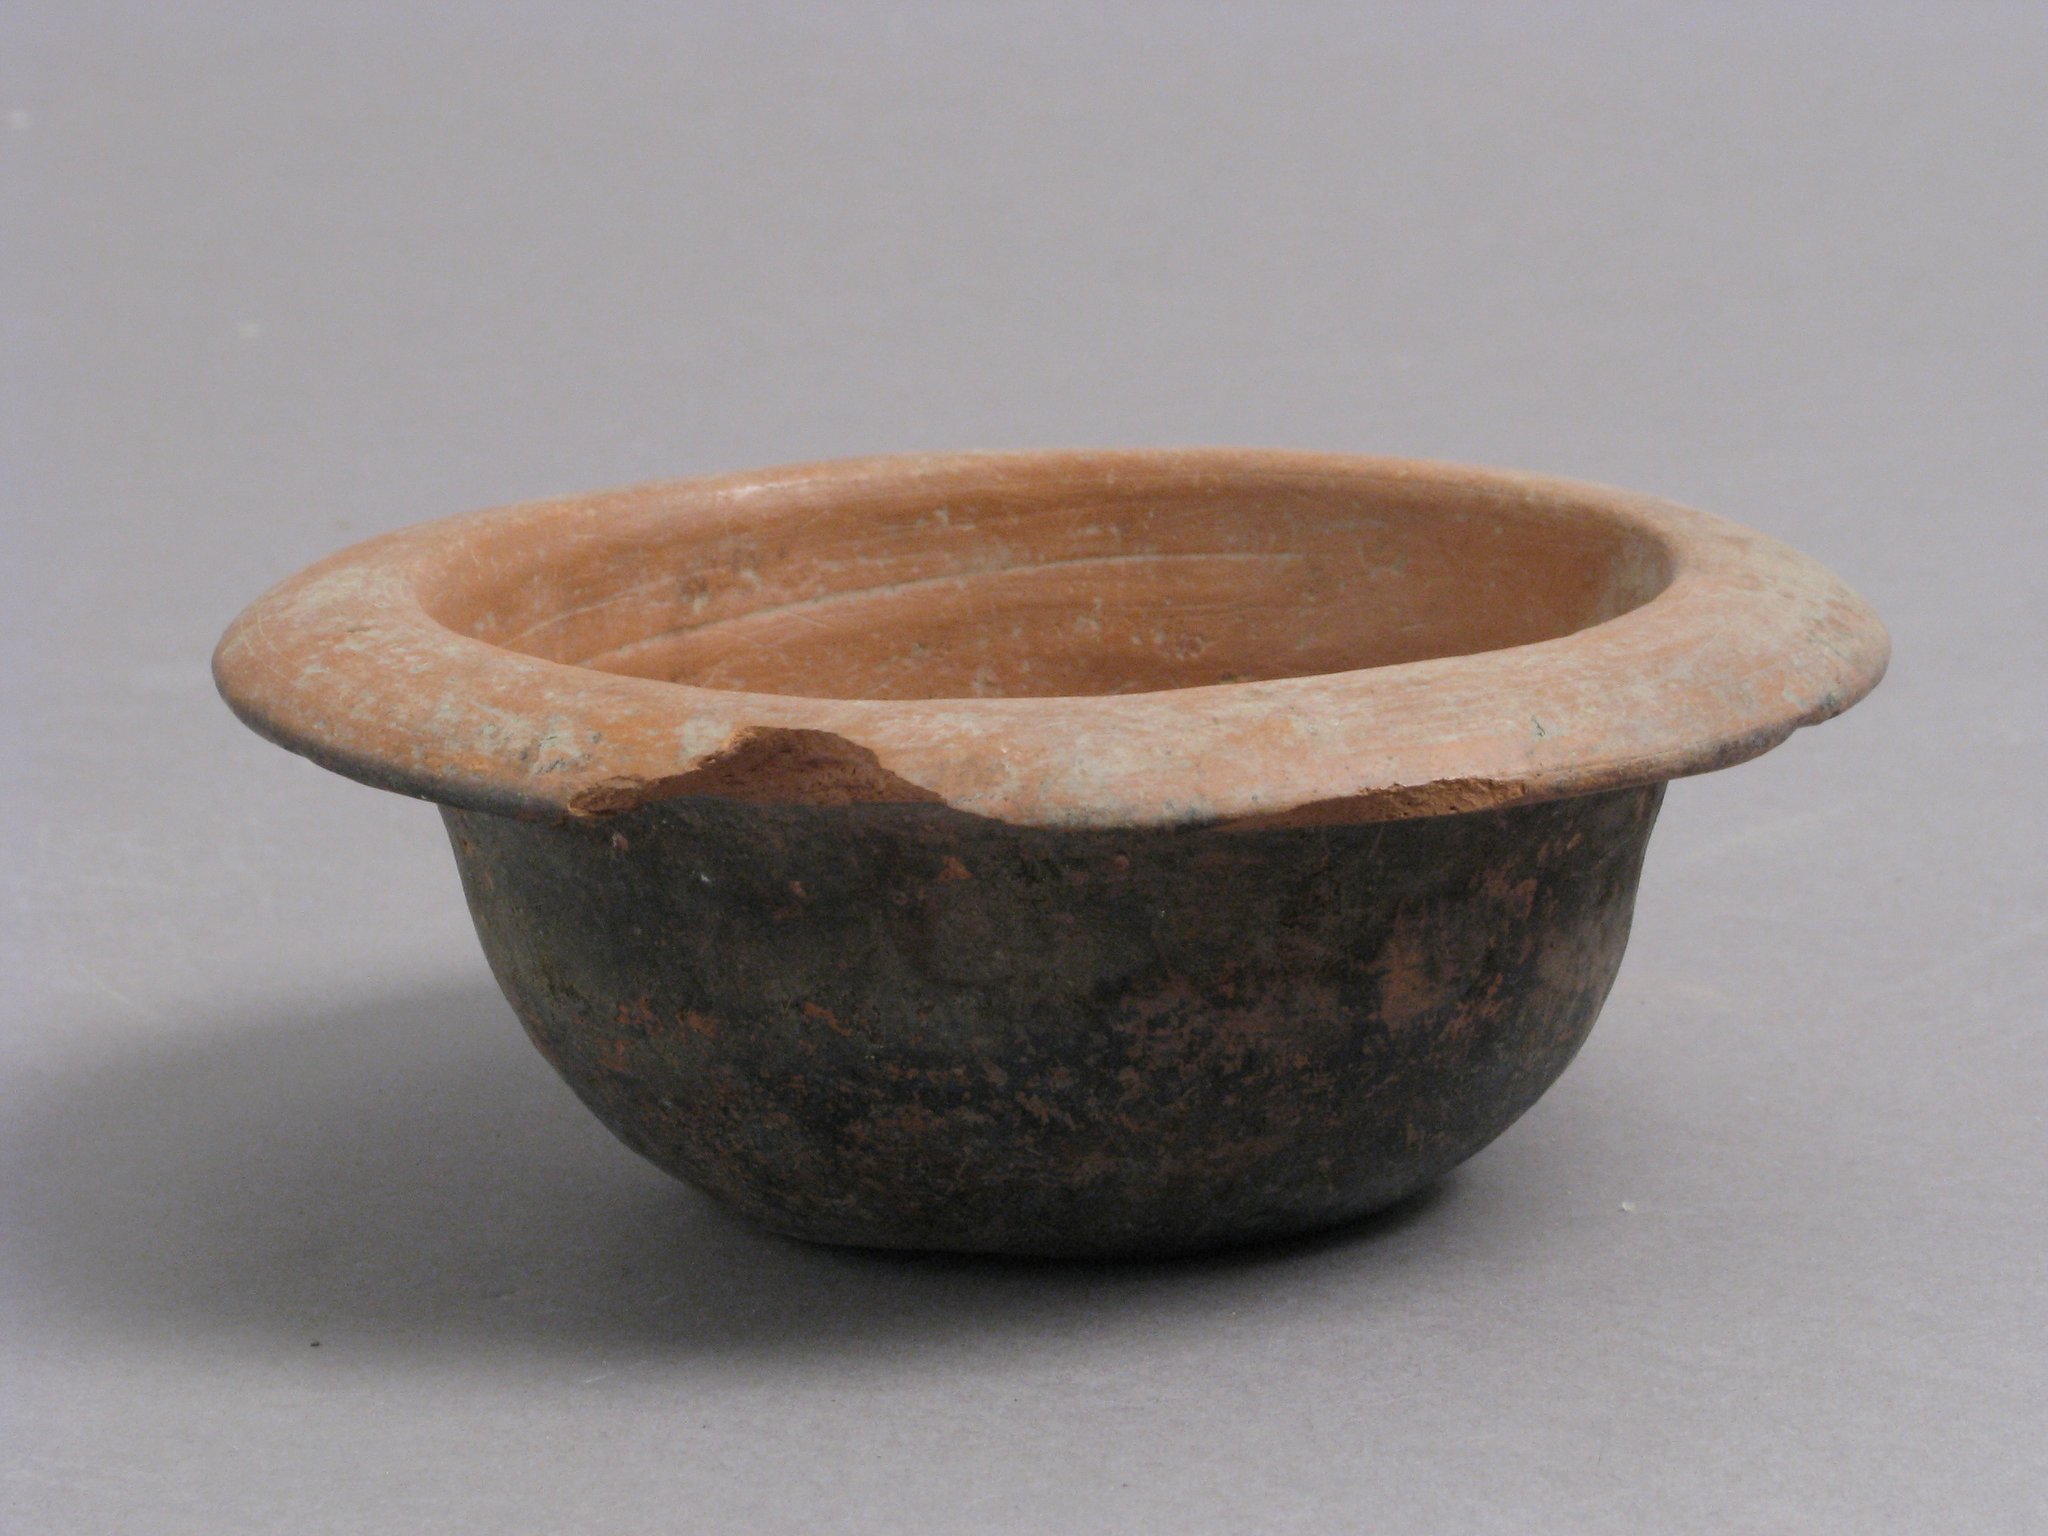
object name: bowl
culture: coptic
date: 301-700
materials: earthenware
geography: egypt